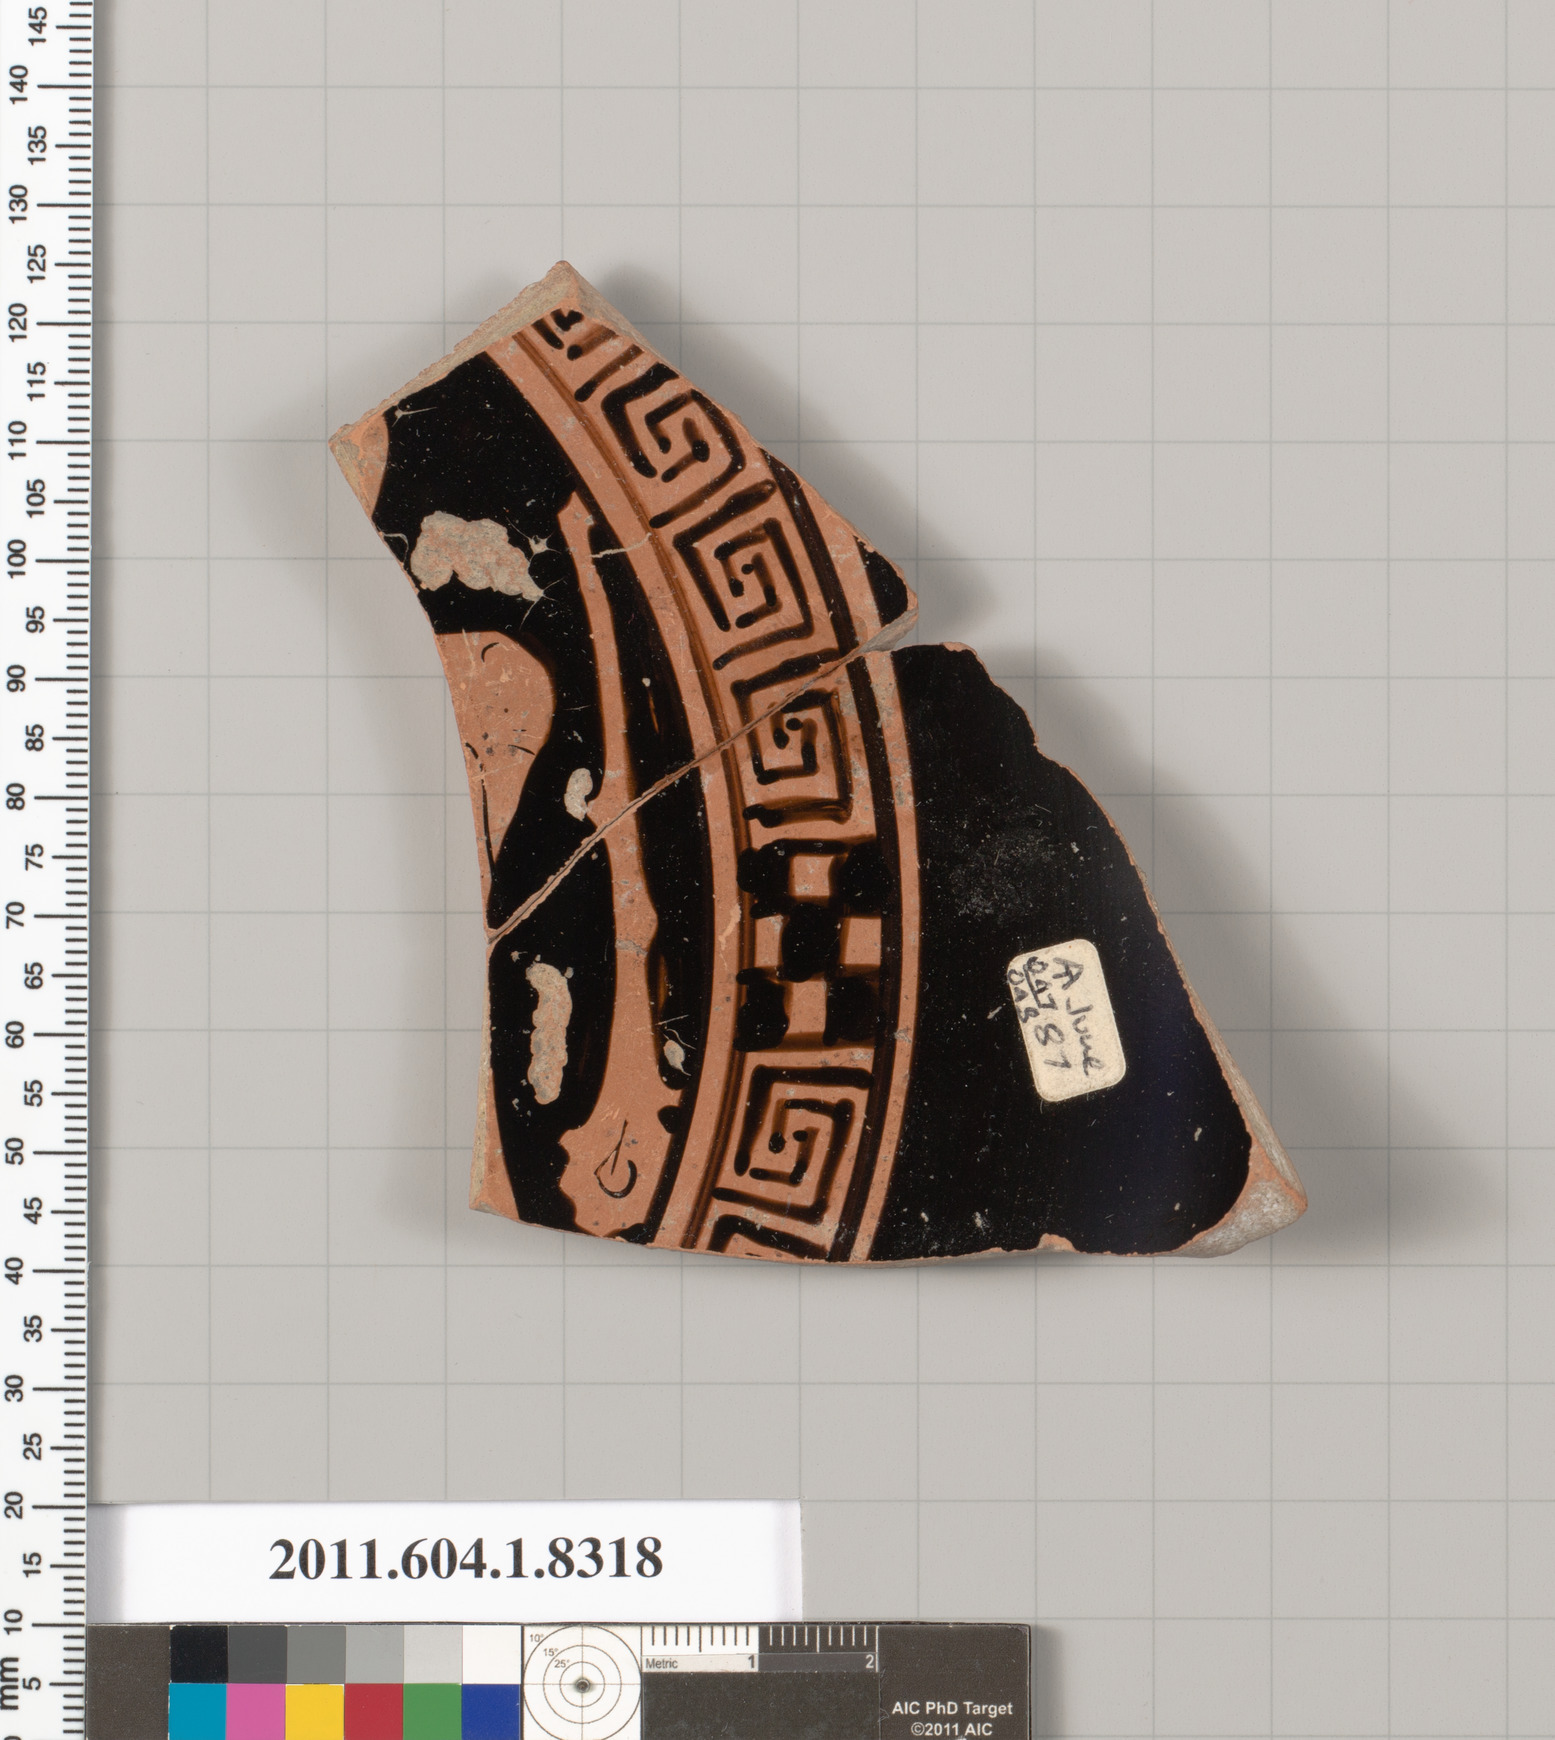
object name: kylix fragment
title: Terracotta fragment of a kylix (drinking cup)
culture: greek, attic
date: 400-376 BCE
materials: terracotta